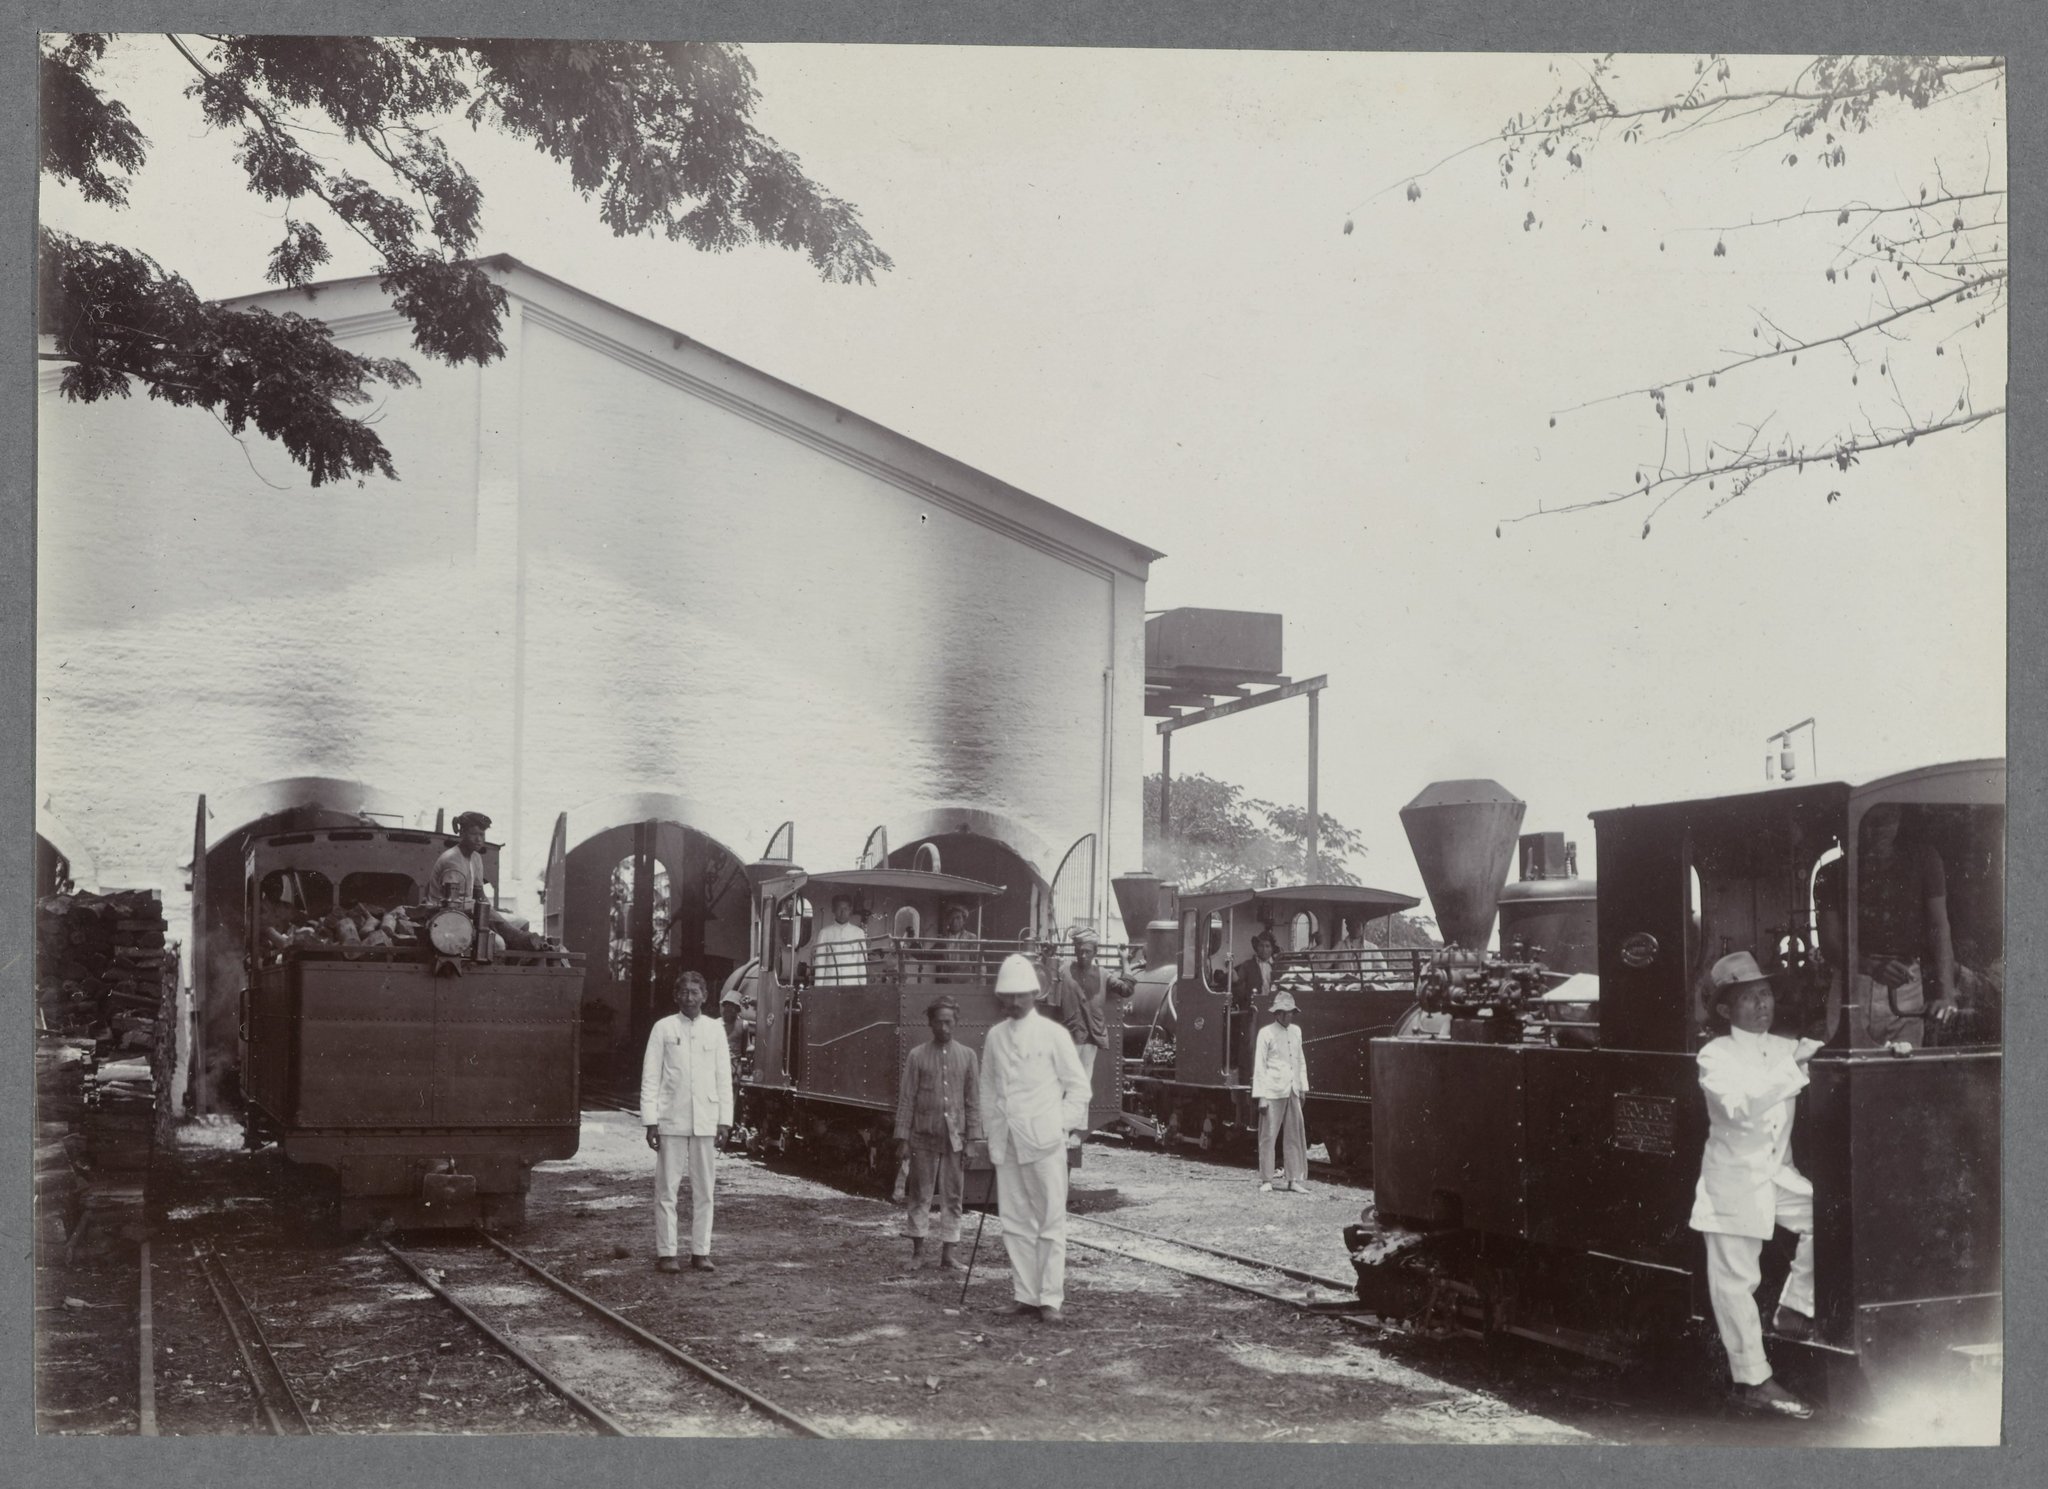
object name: photograph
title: Lokomotieven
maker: Anonymous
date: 1900-1919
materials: photographic support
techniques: collodion silver print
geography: comal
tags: colonial system, locomotive, (non-fruit) products of plants or trees: sugarcane, personnel in modern industry, exterior of industrial structures, factories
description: Lokomotieven bij het fabrieksgebouw of station bij de suikerfabriek. Onderdeel van het fotoalbum van de Tjomal suikerfabriek in de periode ca. 1900-1919.